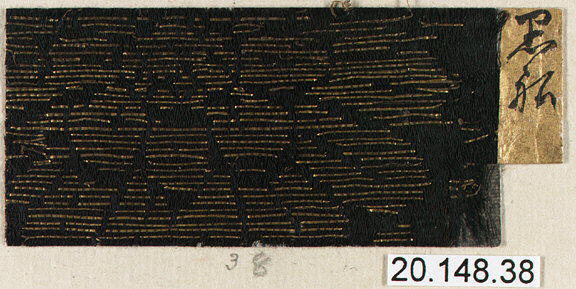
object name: piece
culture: japanese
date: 1401-1500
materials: silk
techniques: compound weave